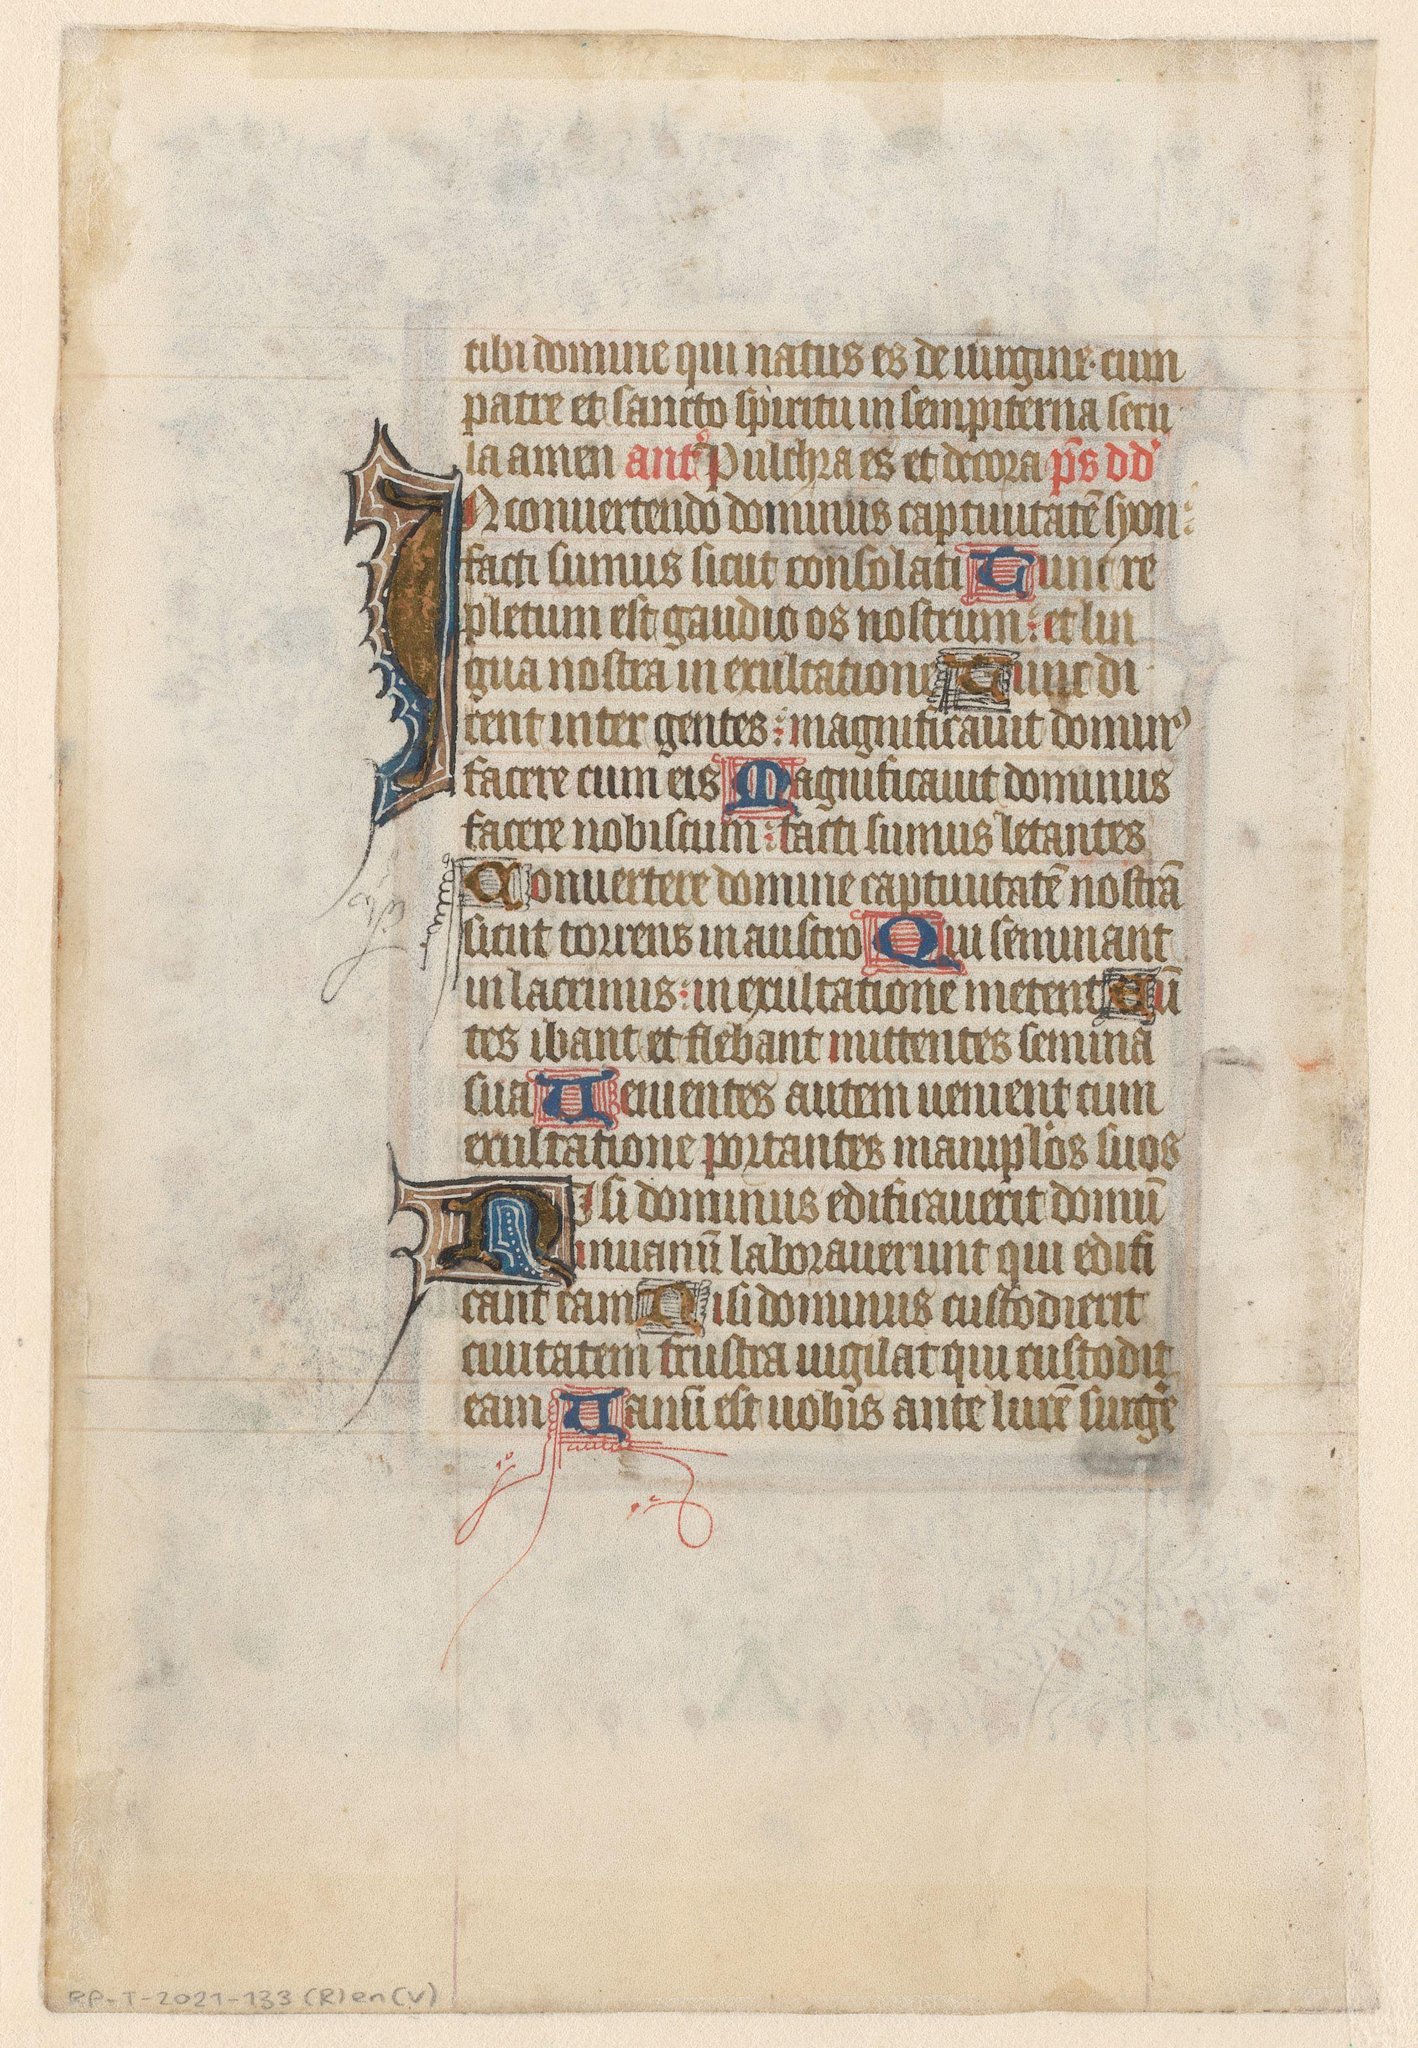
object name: drawing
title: Blad uit een brevier of missaal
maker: Anonymous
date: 1300-1399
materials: paint, gold leaf, ink, parchment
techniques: brush, pen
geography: france